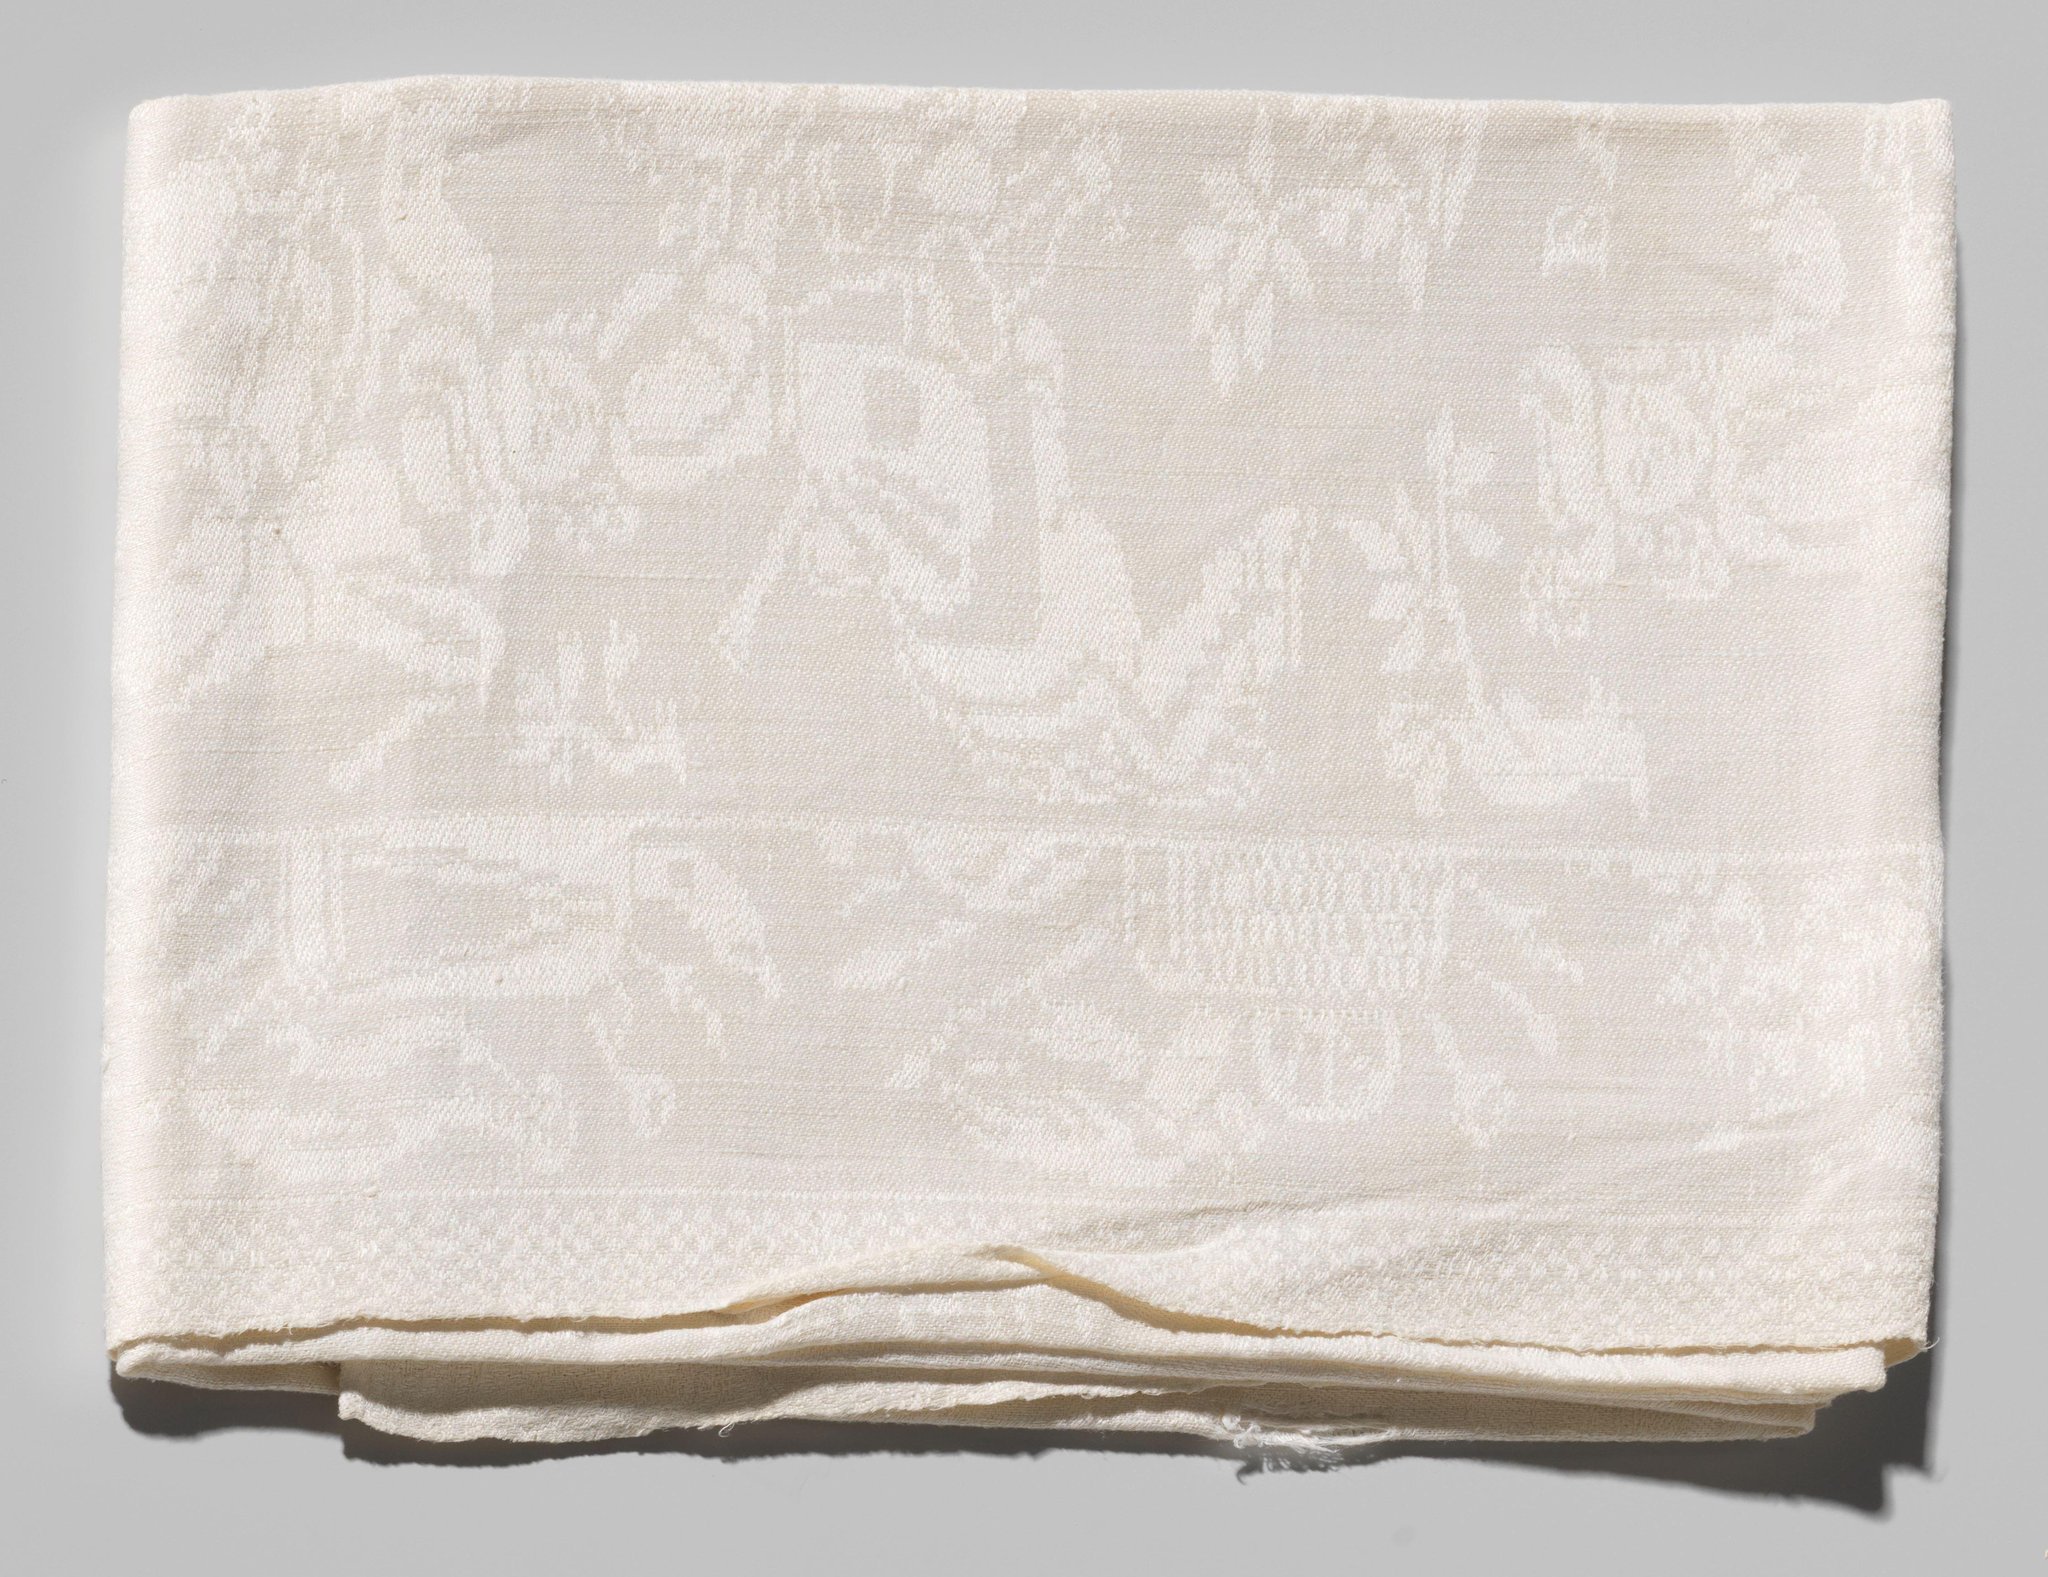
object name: napkin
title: Servet met wapenfeiten uit de Spaanse successieoorlog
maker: Anonymous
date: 1700-1724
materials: linen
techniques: damask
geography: kortrijk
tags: paris, vienna, eugenius van savoye, lille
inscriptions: mark: ‘EB 12’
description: Servet van linnendamast met wapenfeiten uit de Spaanse successieoorlog. Het symmetrisch verdubbeld patroon vertoont vier taferelen: 1 Een door kanonnen bedreigde stad met het onderschrift TOURNAY. 2 Een kleine citadel wordt omgeven door twee ruiters, die voetvolk meevoeren. Bijschrift: LE BATAILLE BAVEZ. 3 Belegering van RIJSSEL. Bijschrift: LILICIDIUM. 4 Een naar het midden gekeerde galopperende maarschalk. Onderschrift: MONS. Staande randen: gehalveerde trofeeën; rondom: blokkenrand.